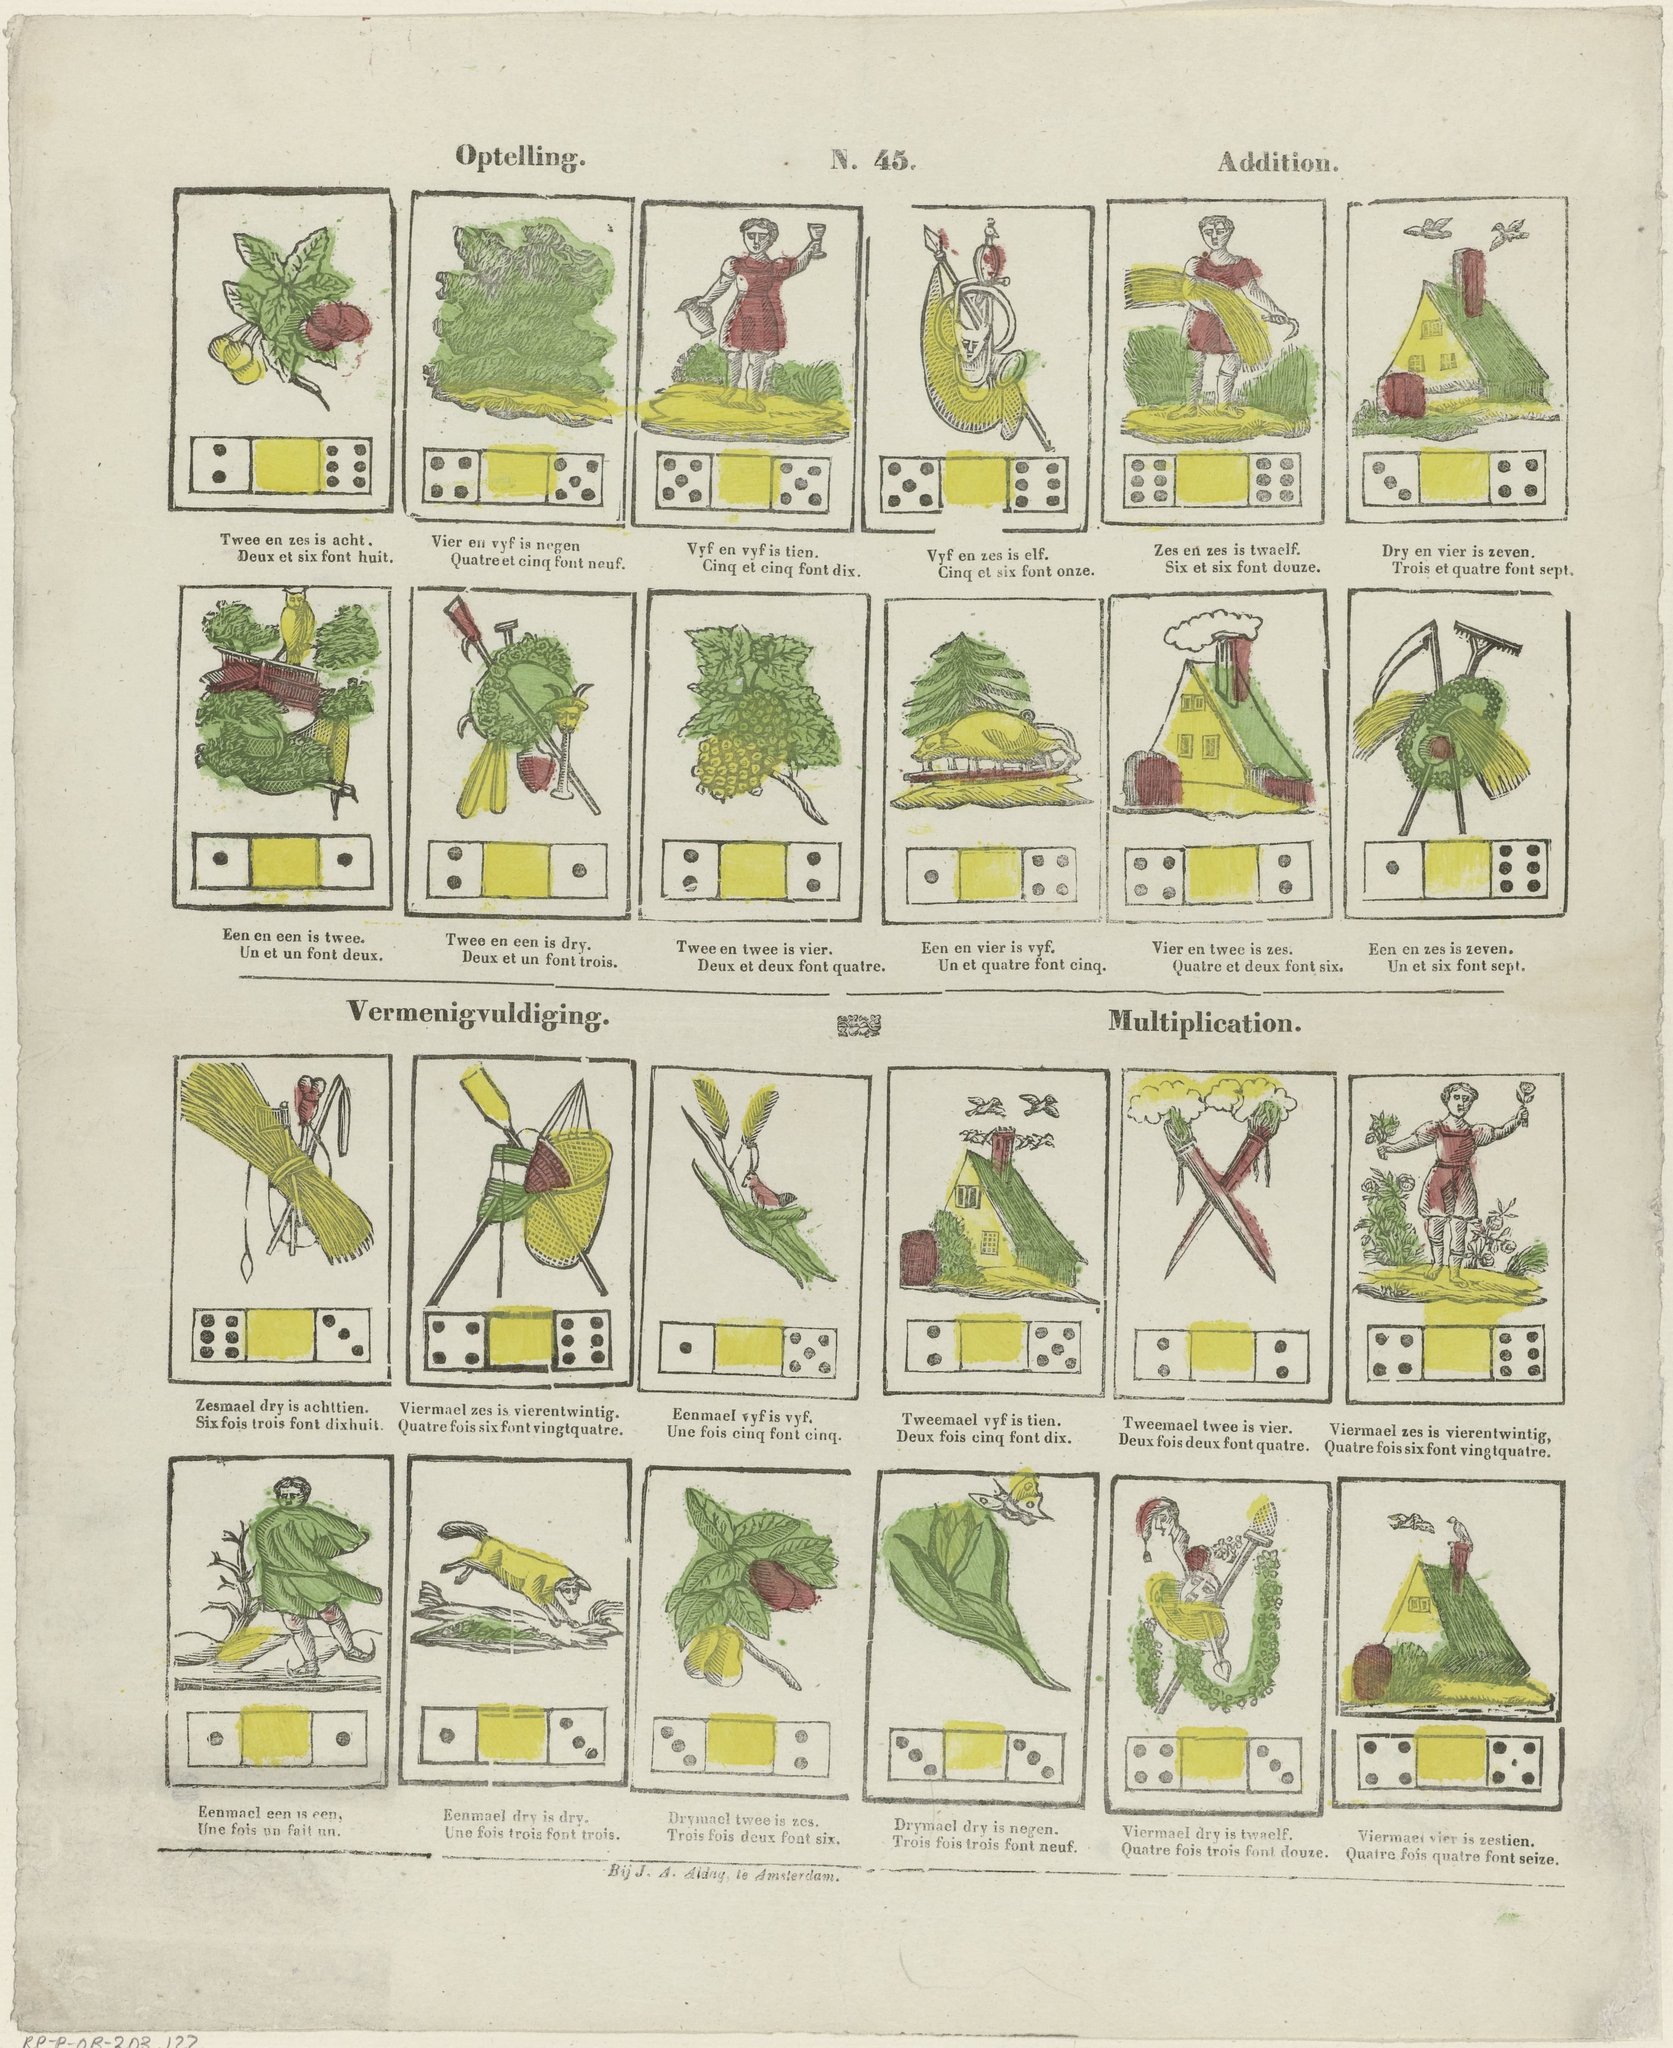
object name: print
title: Optelling / Addition / Vermenigvuldiging / Multiplication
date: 1833-1900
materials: paper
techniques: colour, letterpress printing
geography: amsterdam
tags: characters (human types), dice, counting, calculating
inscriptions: collector's mark: Lugt 2760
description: Blad met 24 voorstellingen van figuren, dieren en voorwerpen. Bij elke afbeelding twee dobbelstenen. Onder elke afbeelding een versje met een rekensom in het Nederlands en in het Frans. Genummerd midden boven: N. 45.